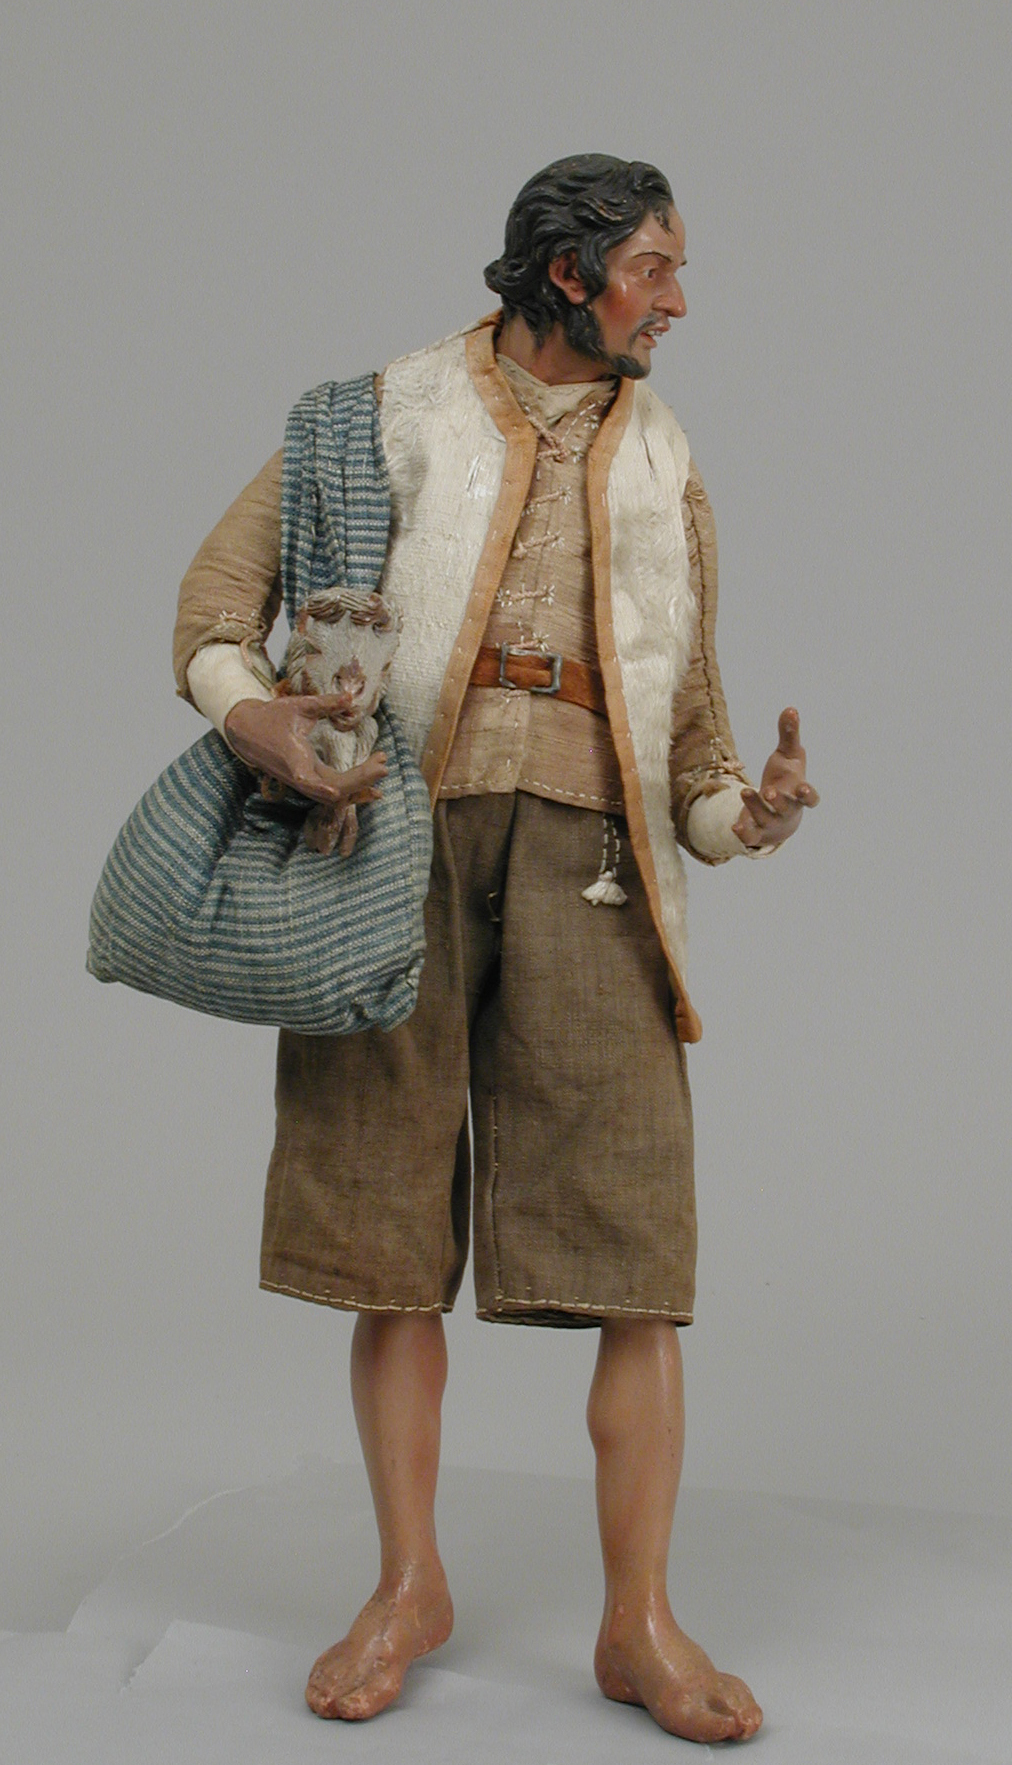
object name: crèche figure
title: Shepherd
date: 1701-1900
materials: textile, leather, linen, silver, terracotta, fiber, metal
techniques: polychrome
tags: men,shepherds